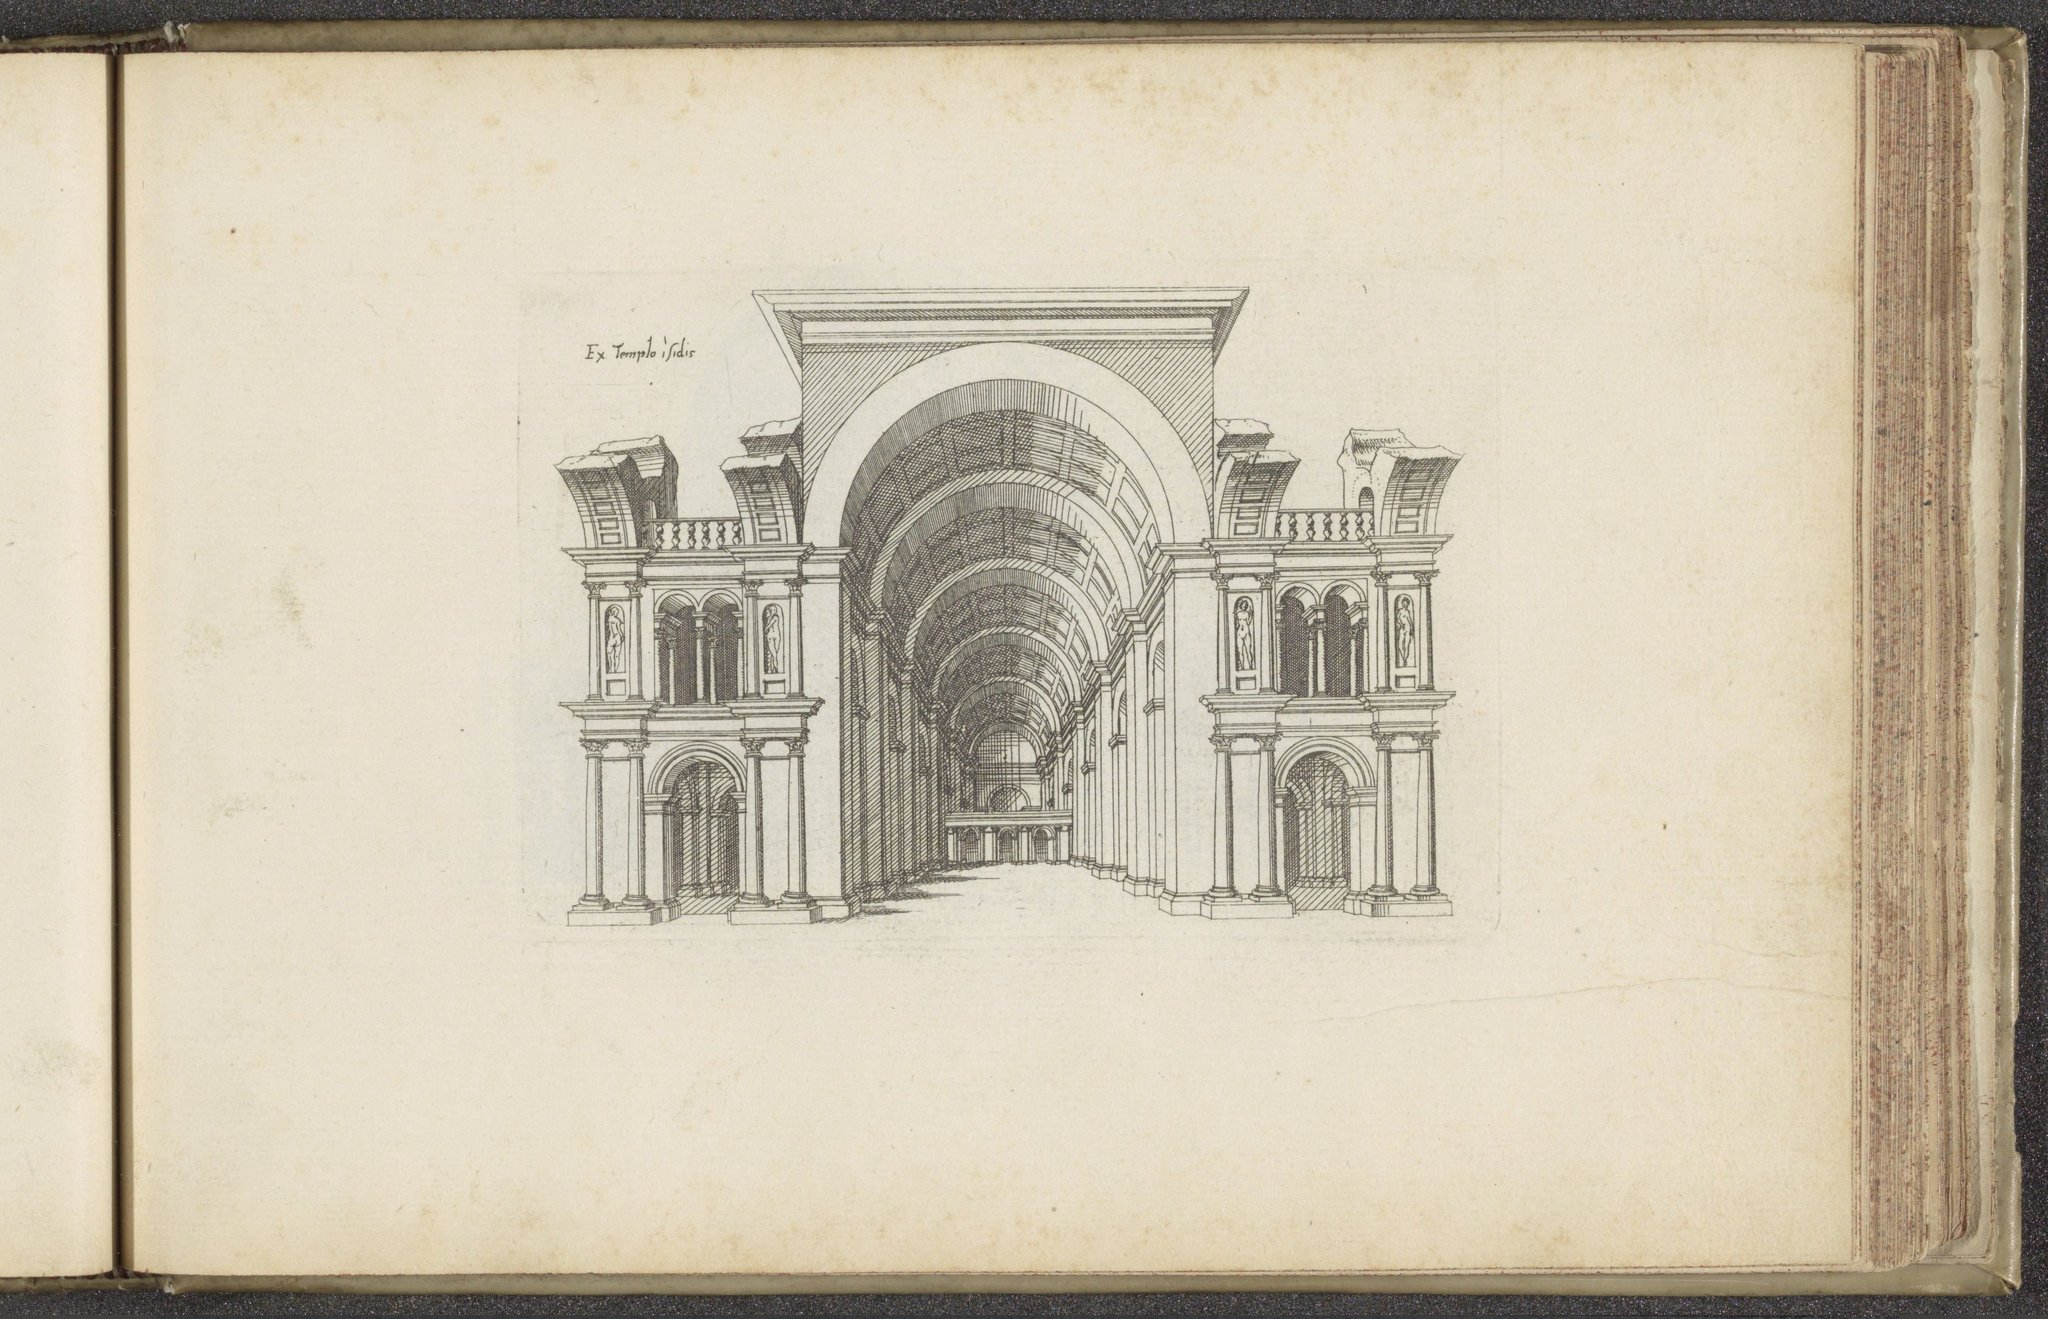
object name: print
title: Tempel van Isis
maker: jacques androuet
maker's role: draughtsman, print maker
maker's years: 1515-1584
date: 1550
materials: paper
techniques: etching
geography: orléans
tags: temple, shrine ~ roman religion, exterior ~ representation of a building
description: Tempel van Isis. Zicht in een lange gang met tongewelf. Deze prent maakt deel uit van een album.